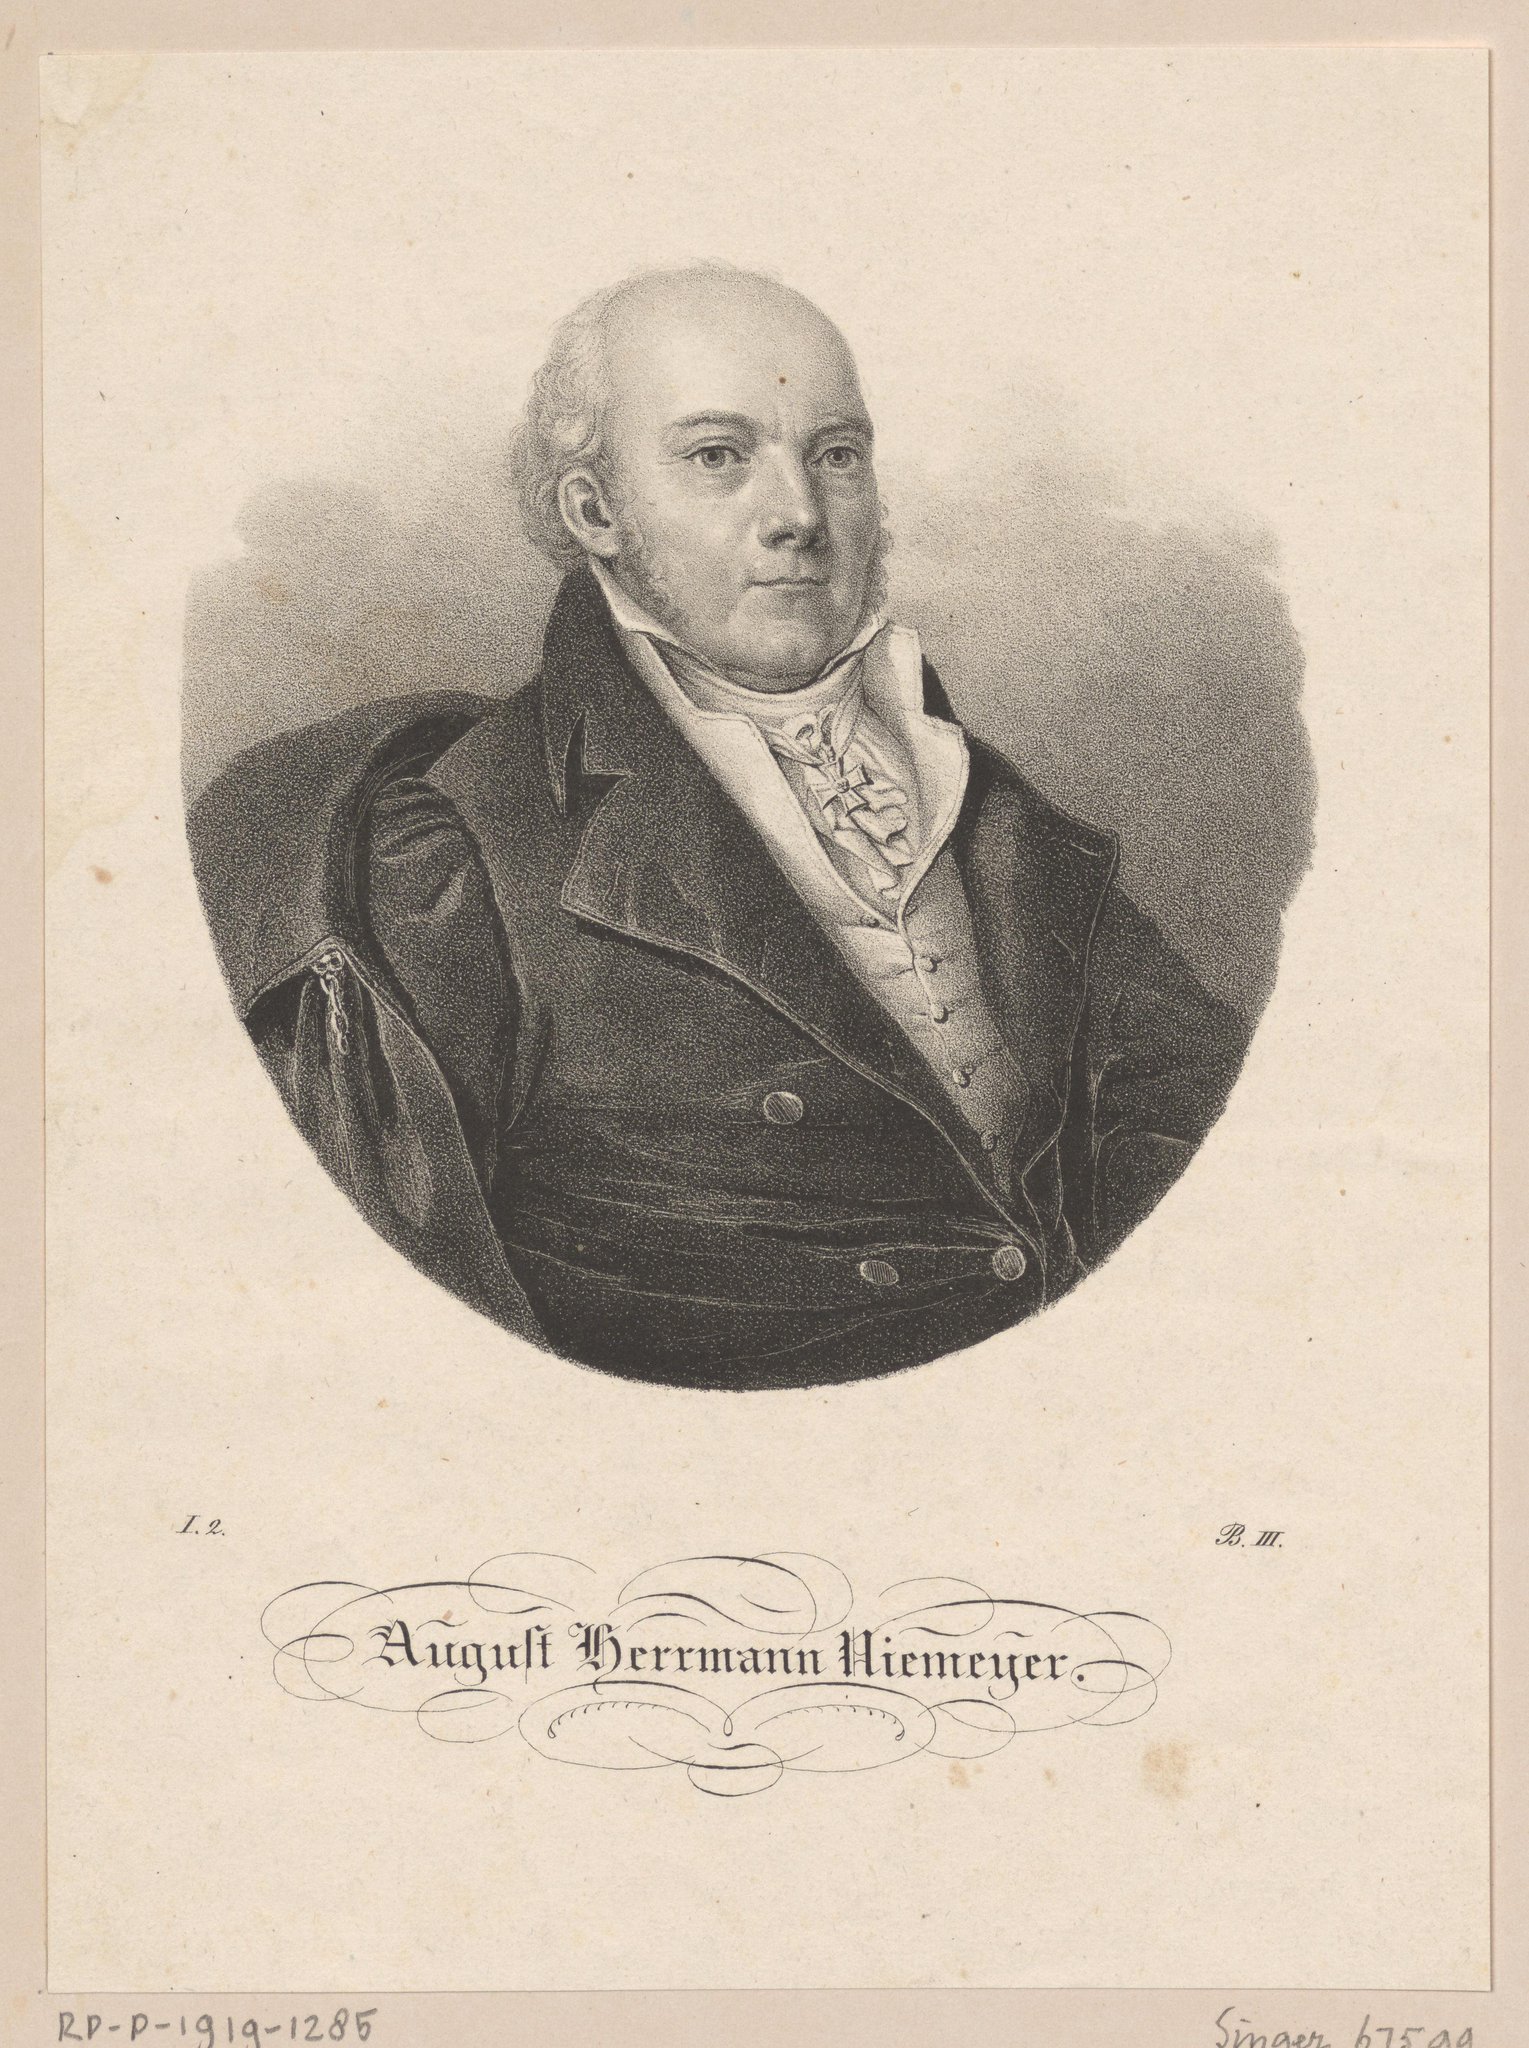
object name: print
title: Portret van August Hermann Niemeyer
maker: Anonymous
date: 1817-1850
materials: paper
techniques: lithograph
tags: theologian, historical persons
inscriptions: collector's mark: Lugt 2228